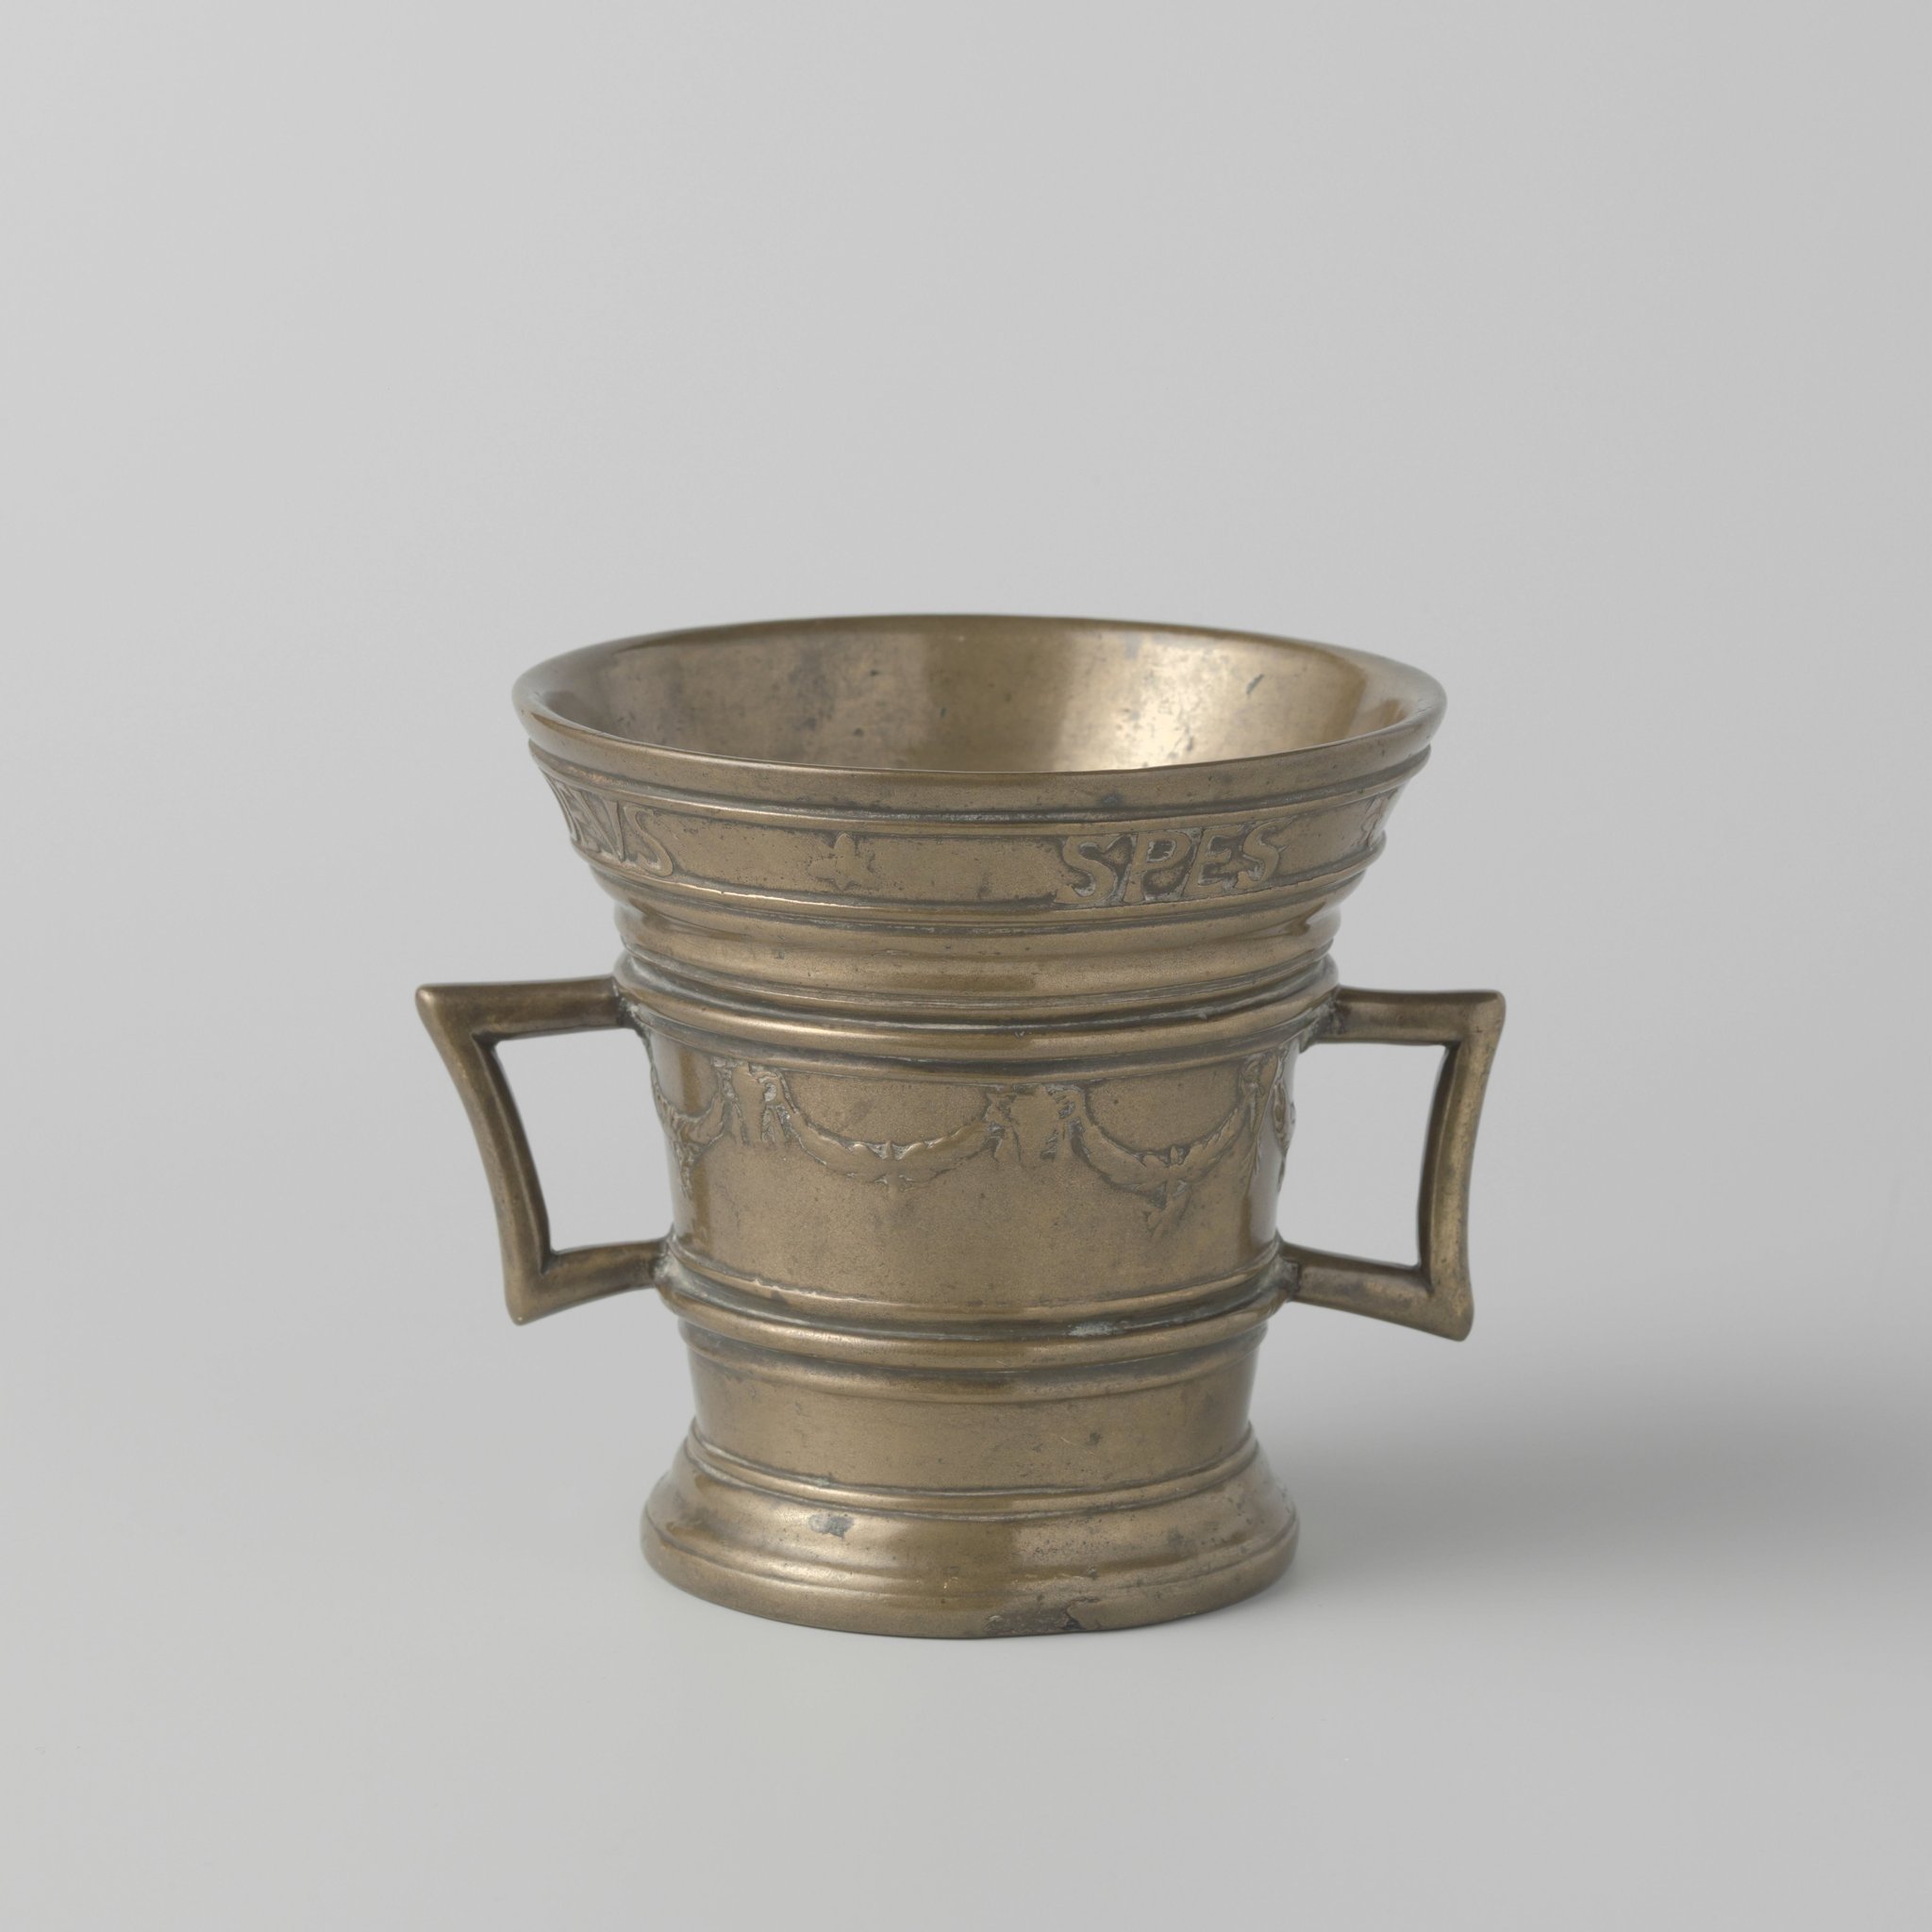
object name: mortar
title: Vijzel met opschrift: DEVS SPES MEA 1565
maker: thomas both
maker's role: brazier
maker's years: 1530-1593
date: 1565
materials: bronze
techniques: casting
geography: utrecht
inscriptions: inscription: ‘DEVS.SPES.MEA.1565.’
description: Mortar and pestle. Bronze (mortar), brass (pestle). Netherlands, 1565.